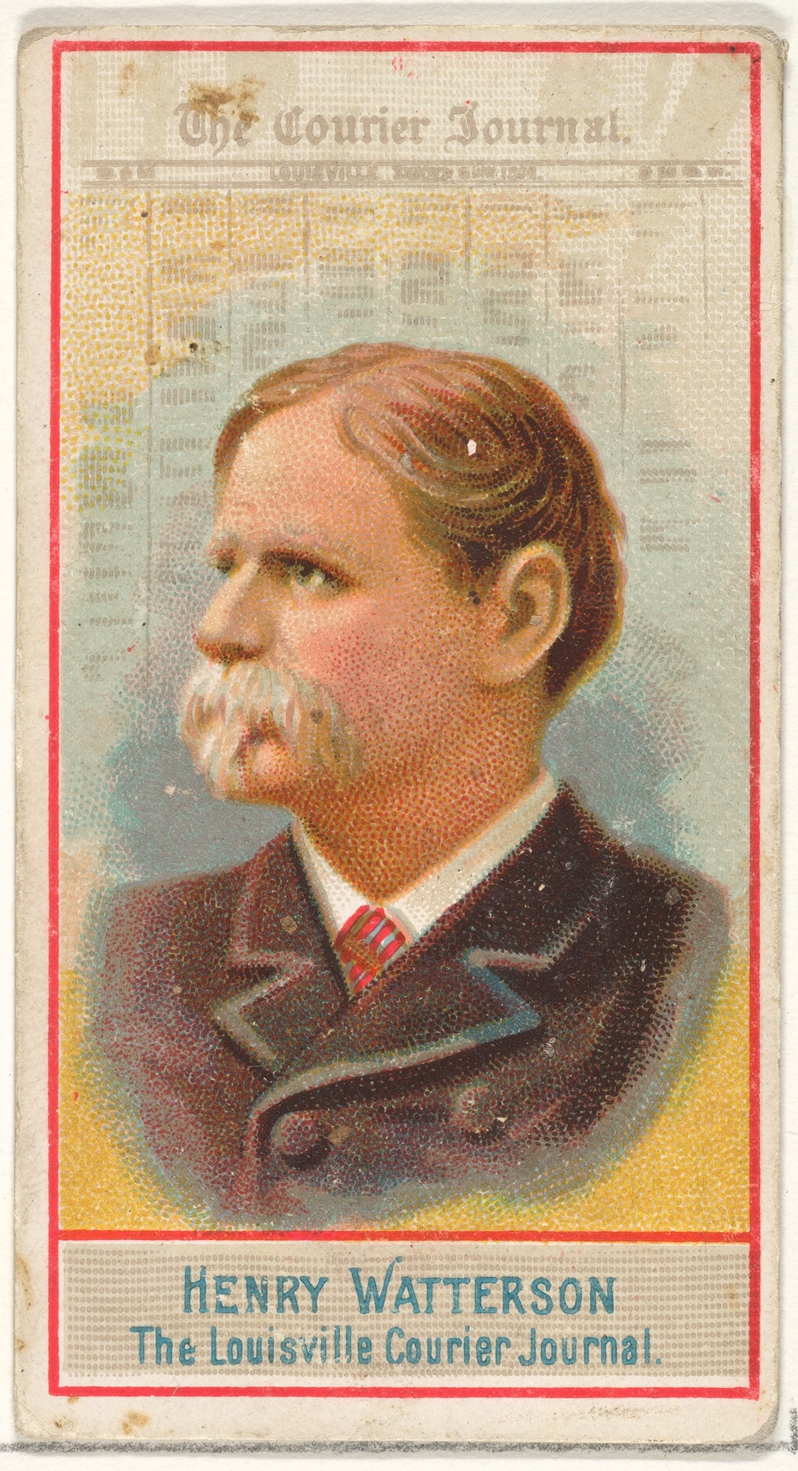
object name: print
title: Henry Watterson, The Louisville Courier Journal, from the American Editors series (N1) for Allen & Ginter Cigarettes Brands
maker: allen & ginter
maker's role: publisher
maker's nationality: american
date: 1887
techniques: color lithograph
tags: men